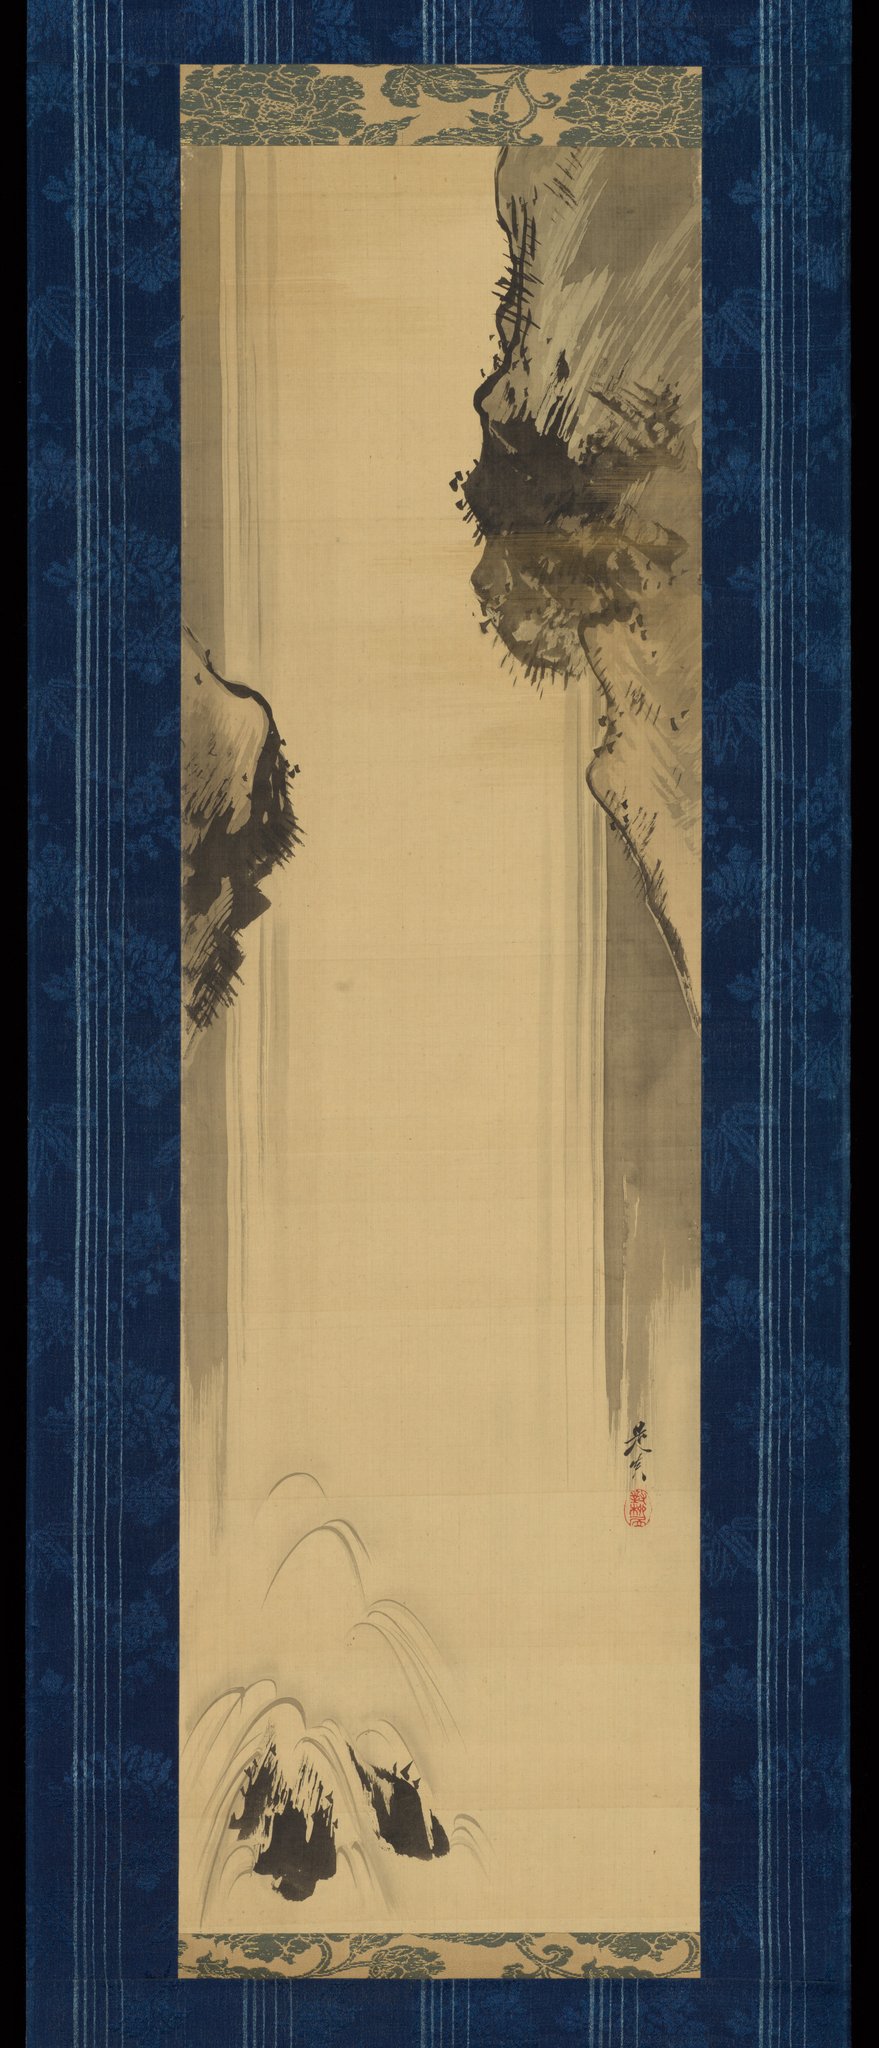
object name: hanging scroll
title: Rocks and Waterfall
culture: japanese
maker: shibata zeshin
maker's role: artist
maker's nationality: japanese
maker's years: 1807-1891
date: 1807-1891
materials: ink, silk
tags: waterfalls